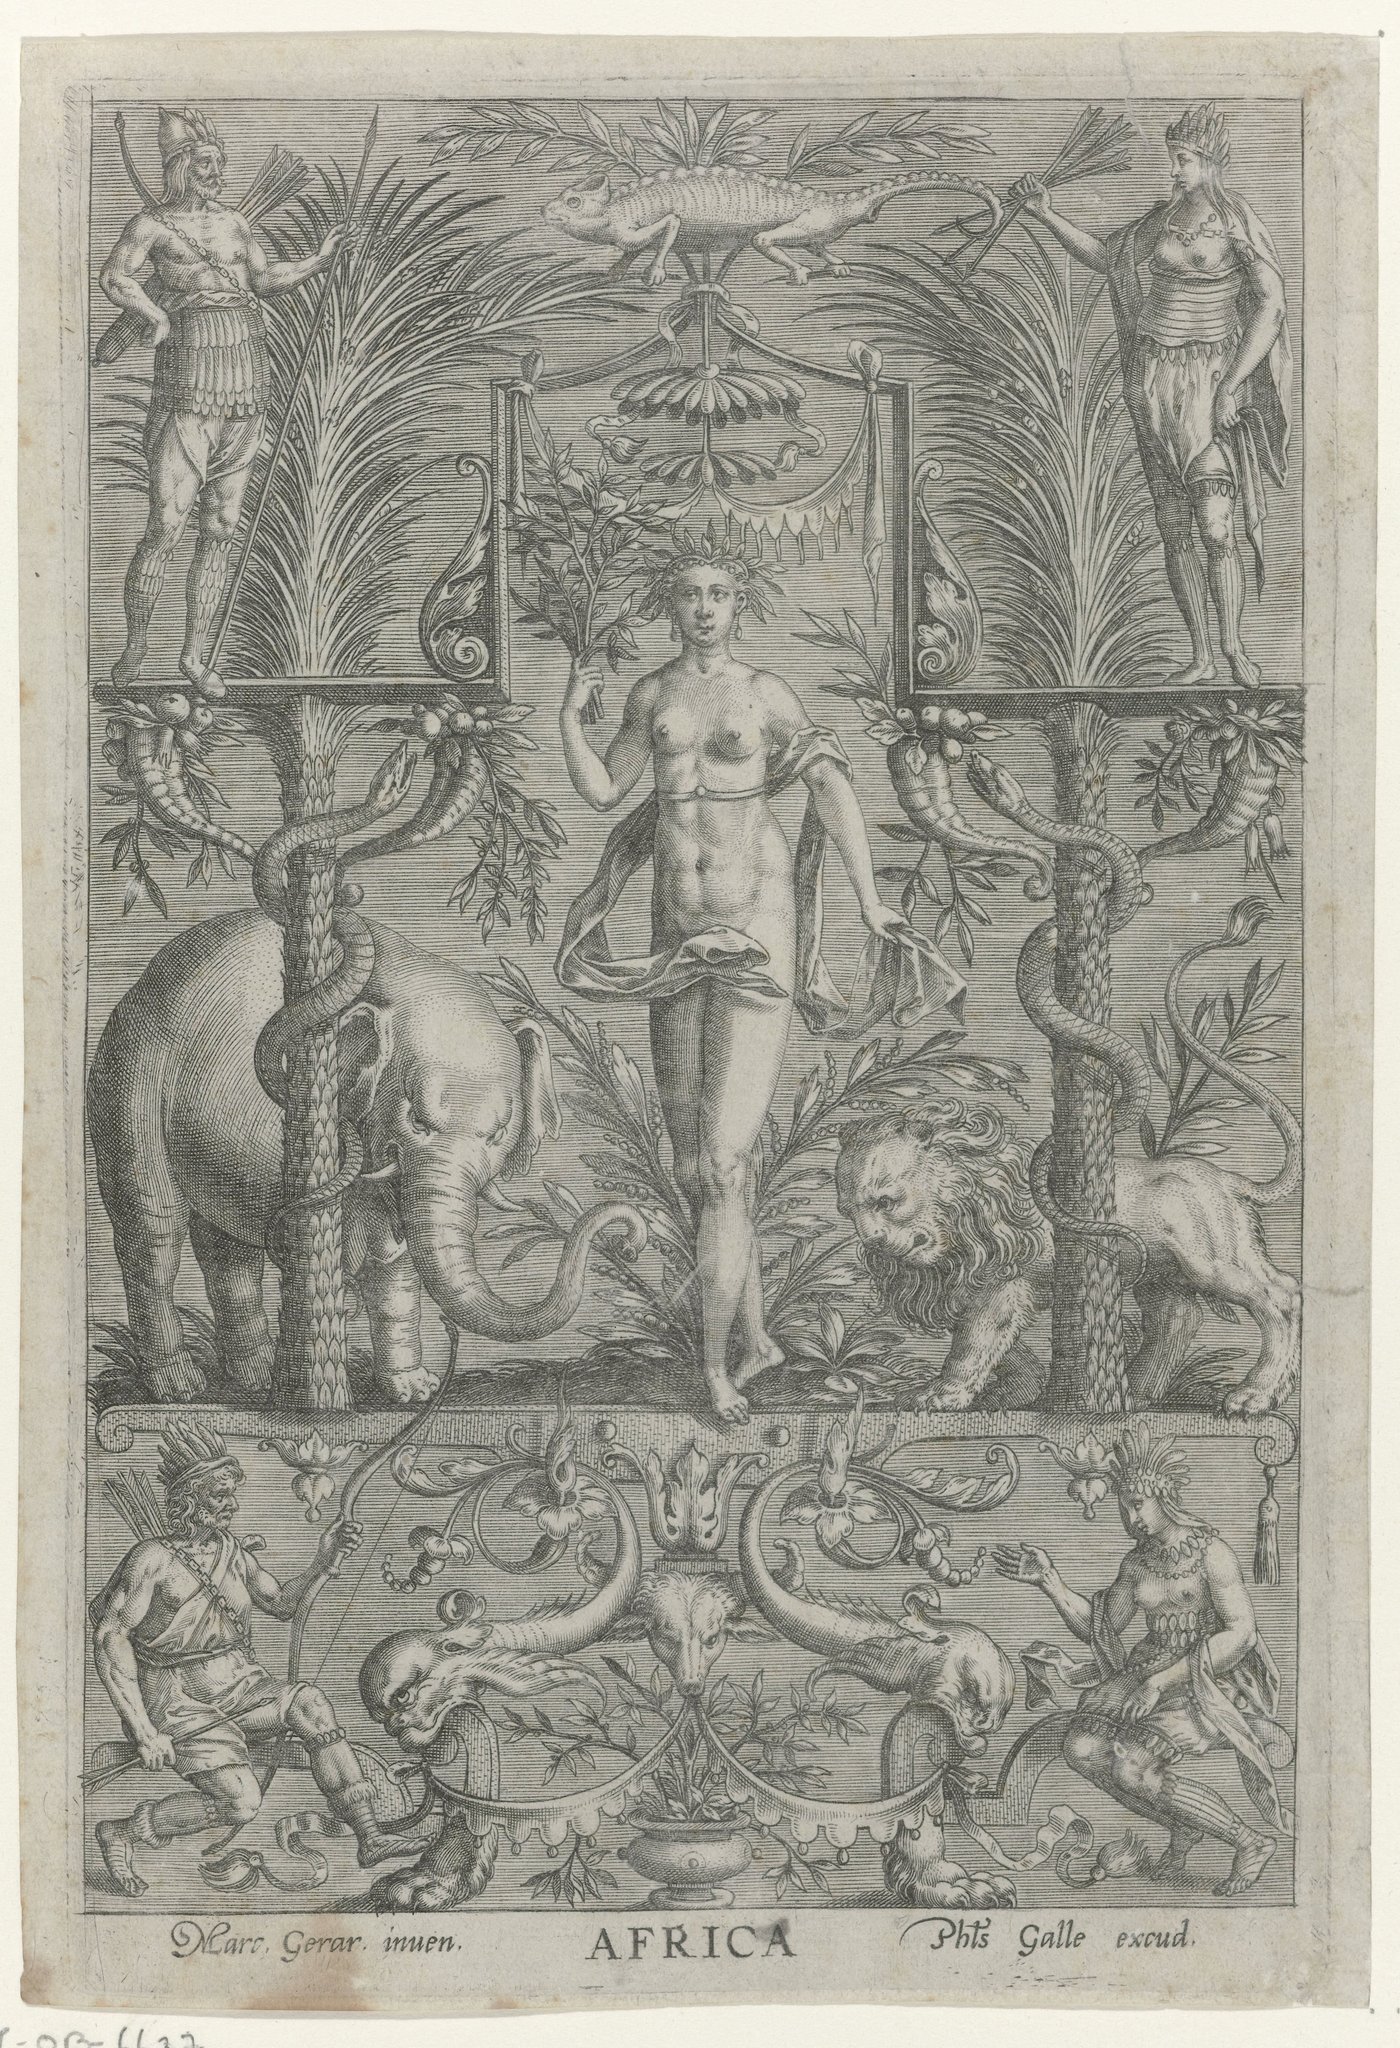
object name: print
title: Africa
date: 1547-1622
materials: paper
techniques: engraving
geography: antwerp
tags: ornament ~ arabesque, africa represented allegorically; 'africa' (ripa)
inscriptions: collector's mark: Lugt 2228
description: De personificatie van Afrika, staande op een sokkel omringd door ornamentele versieringen. Ze heeft een takkebos in haar handen en wordt geflankeerd door een olifant en een leeuw. Boven haar een kameleon en twee Afrikanen. Onderaan de prent twee zeemonsters. De prent is deel van een reeks over de vier werelddelen.